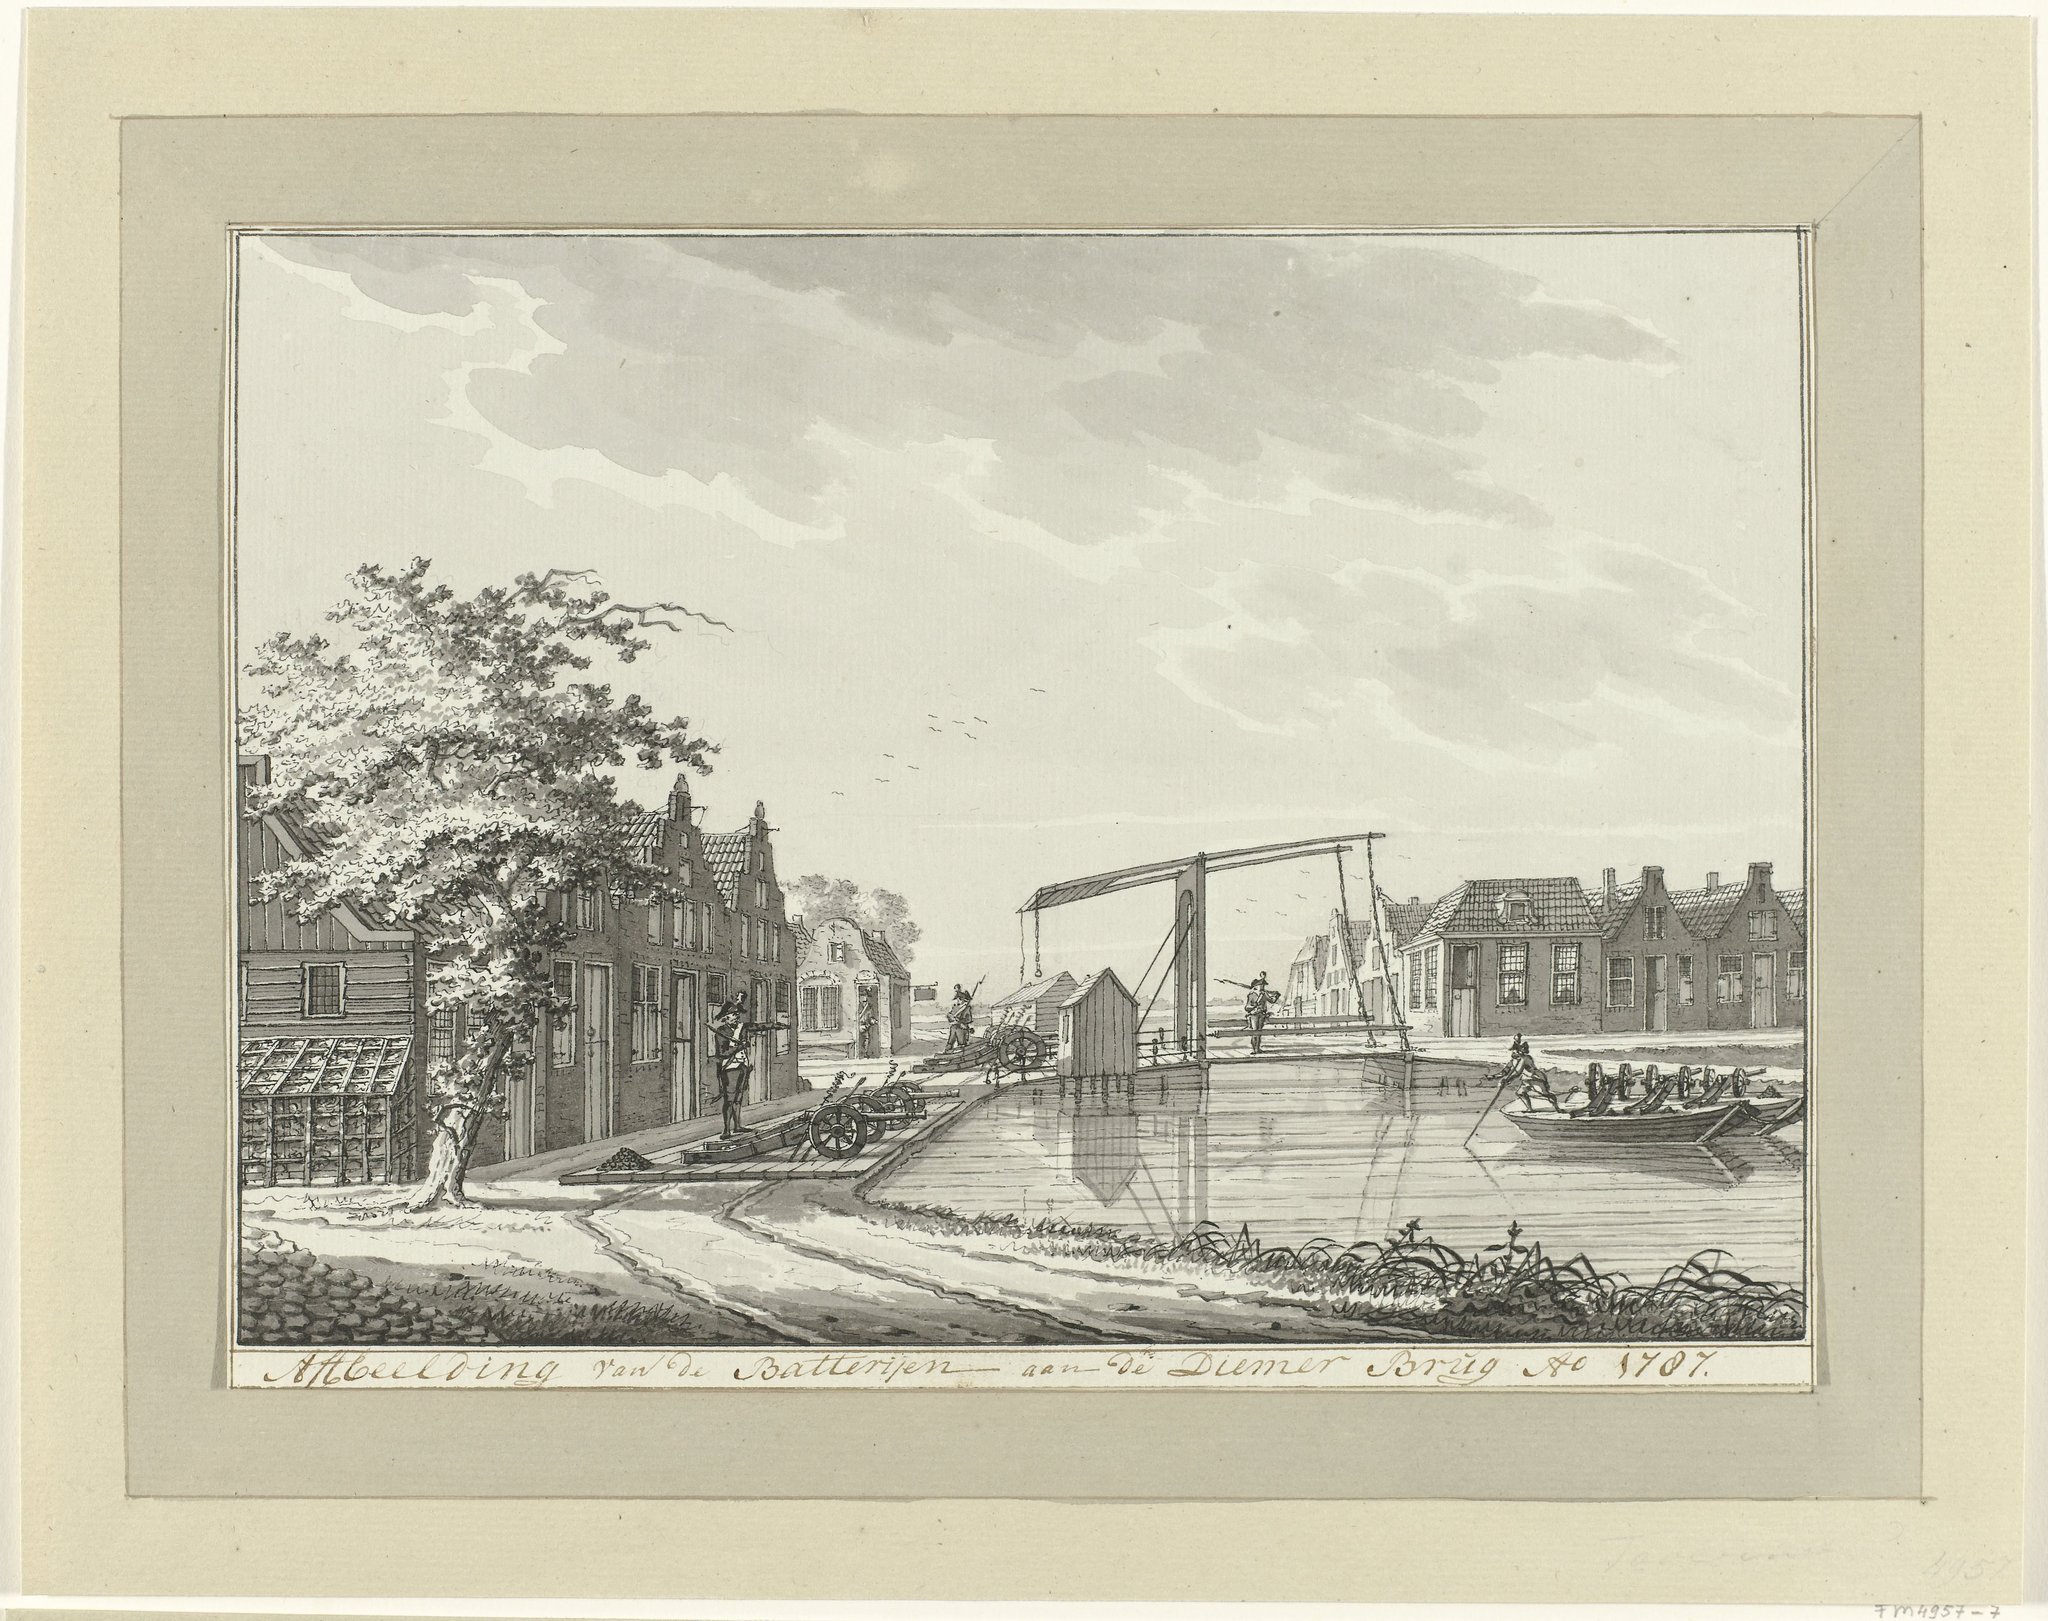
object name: drawing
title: Afbeelding van de Batterijen aan de Diemer Brug Ao 1787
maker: Anonymous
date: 1787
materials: paper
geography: northern netherlands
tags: defence of fortification or city, defensive measures (military)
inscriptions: collector's mark: Lugt 2228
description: Battterij aan de Diemerbrug. Onderdeel van een groep van tien tekeningen van de verdedigingen aangelegd door de patriotten rondom Amsterdam ten tijde van de inval van de Pruisische troepen in september 1787.